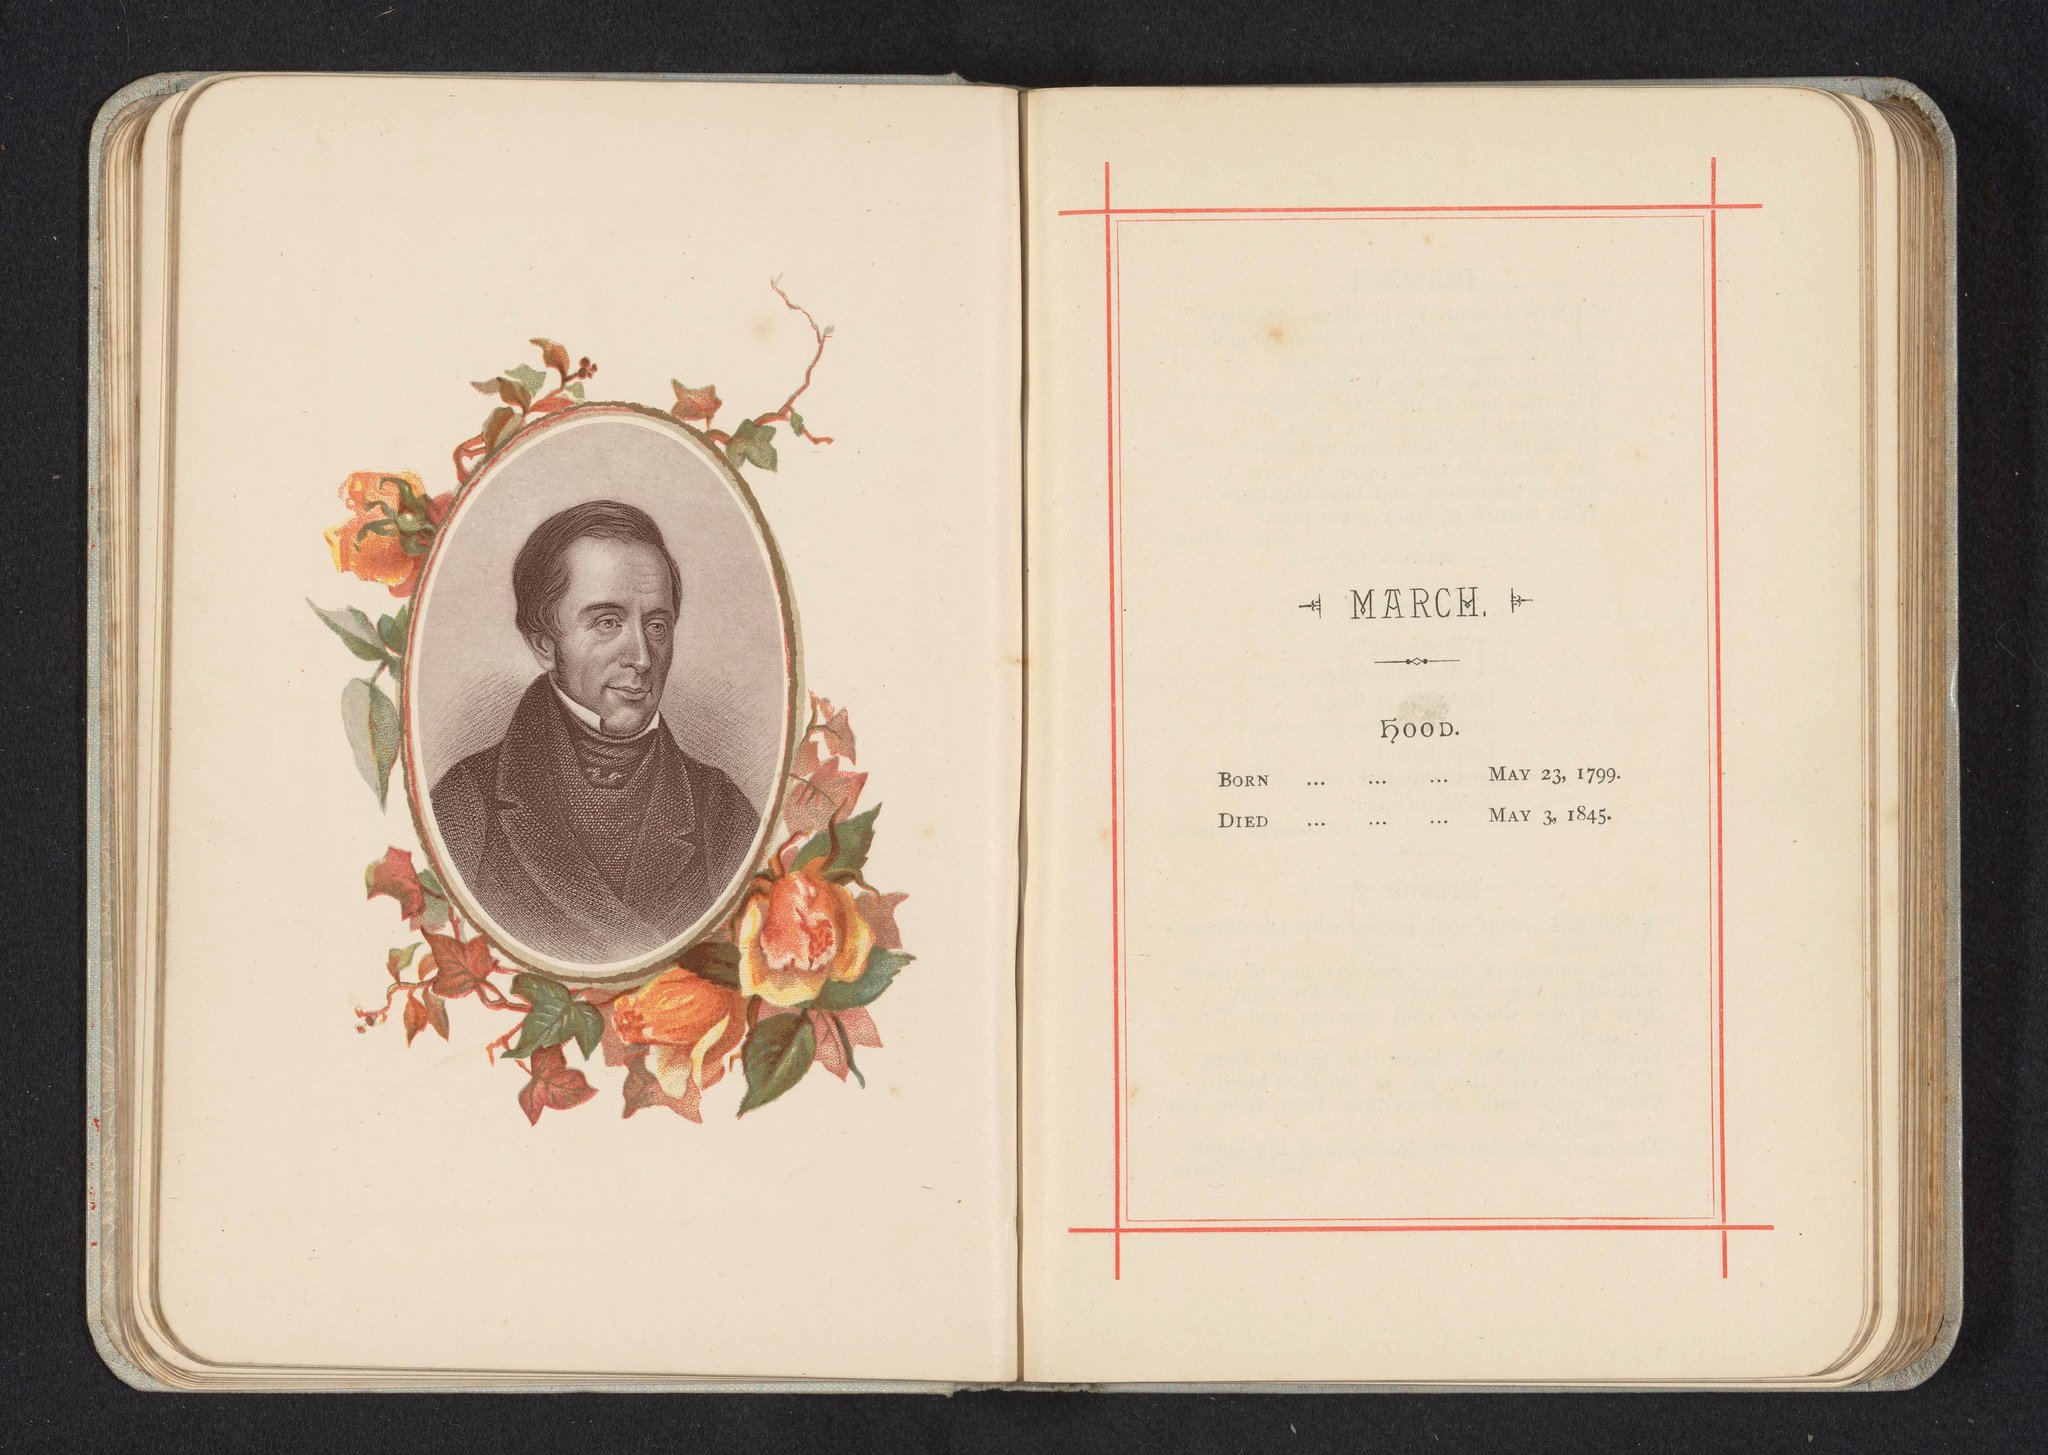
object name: photomechanical print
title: Fotoreproductie van een portret van Thomas Hood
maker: Anonymous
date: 1878-1888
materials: paper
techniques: woodburytype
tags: london, thomas hood, writer, poet, author